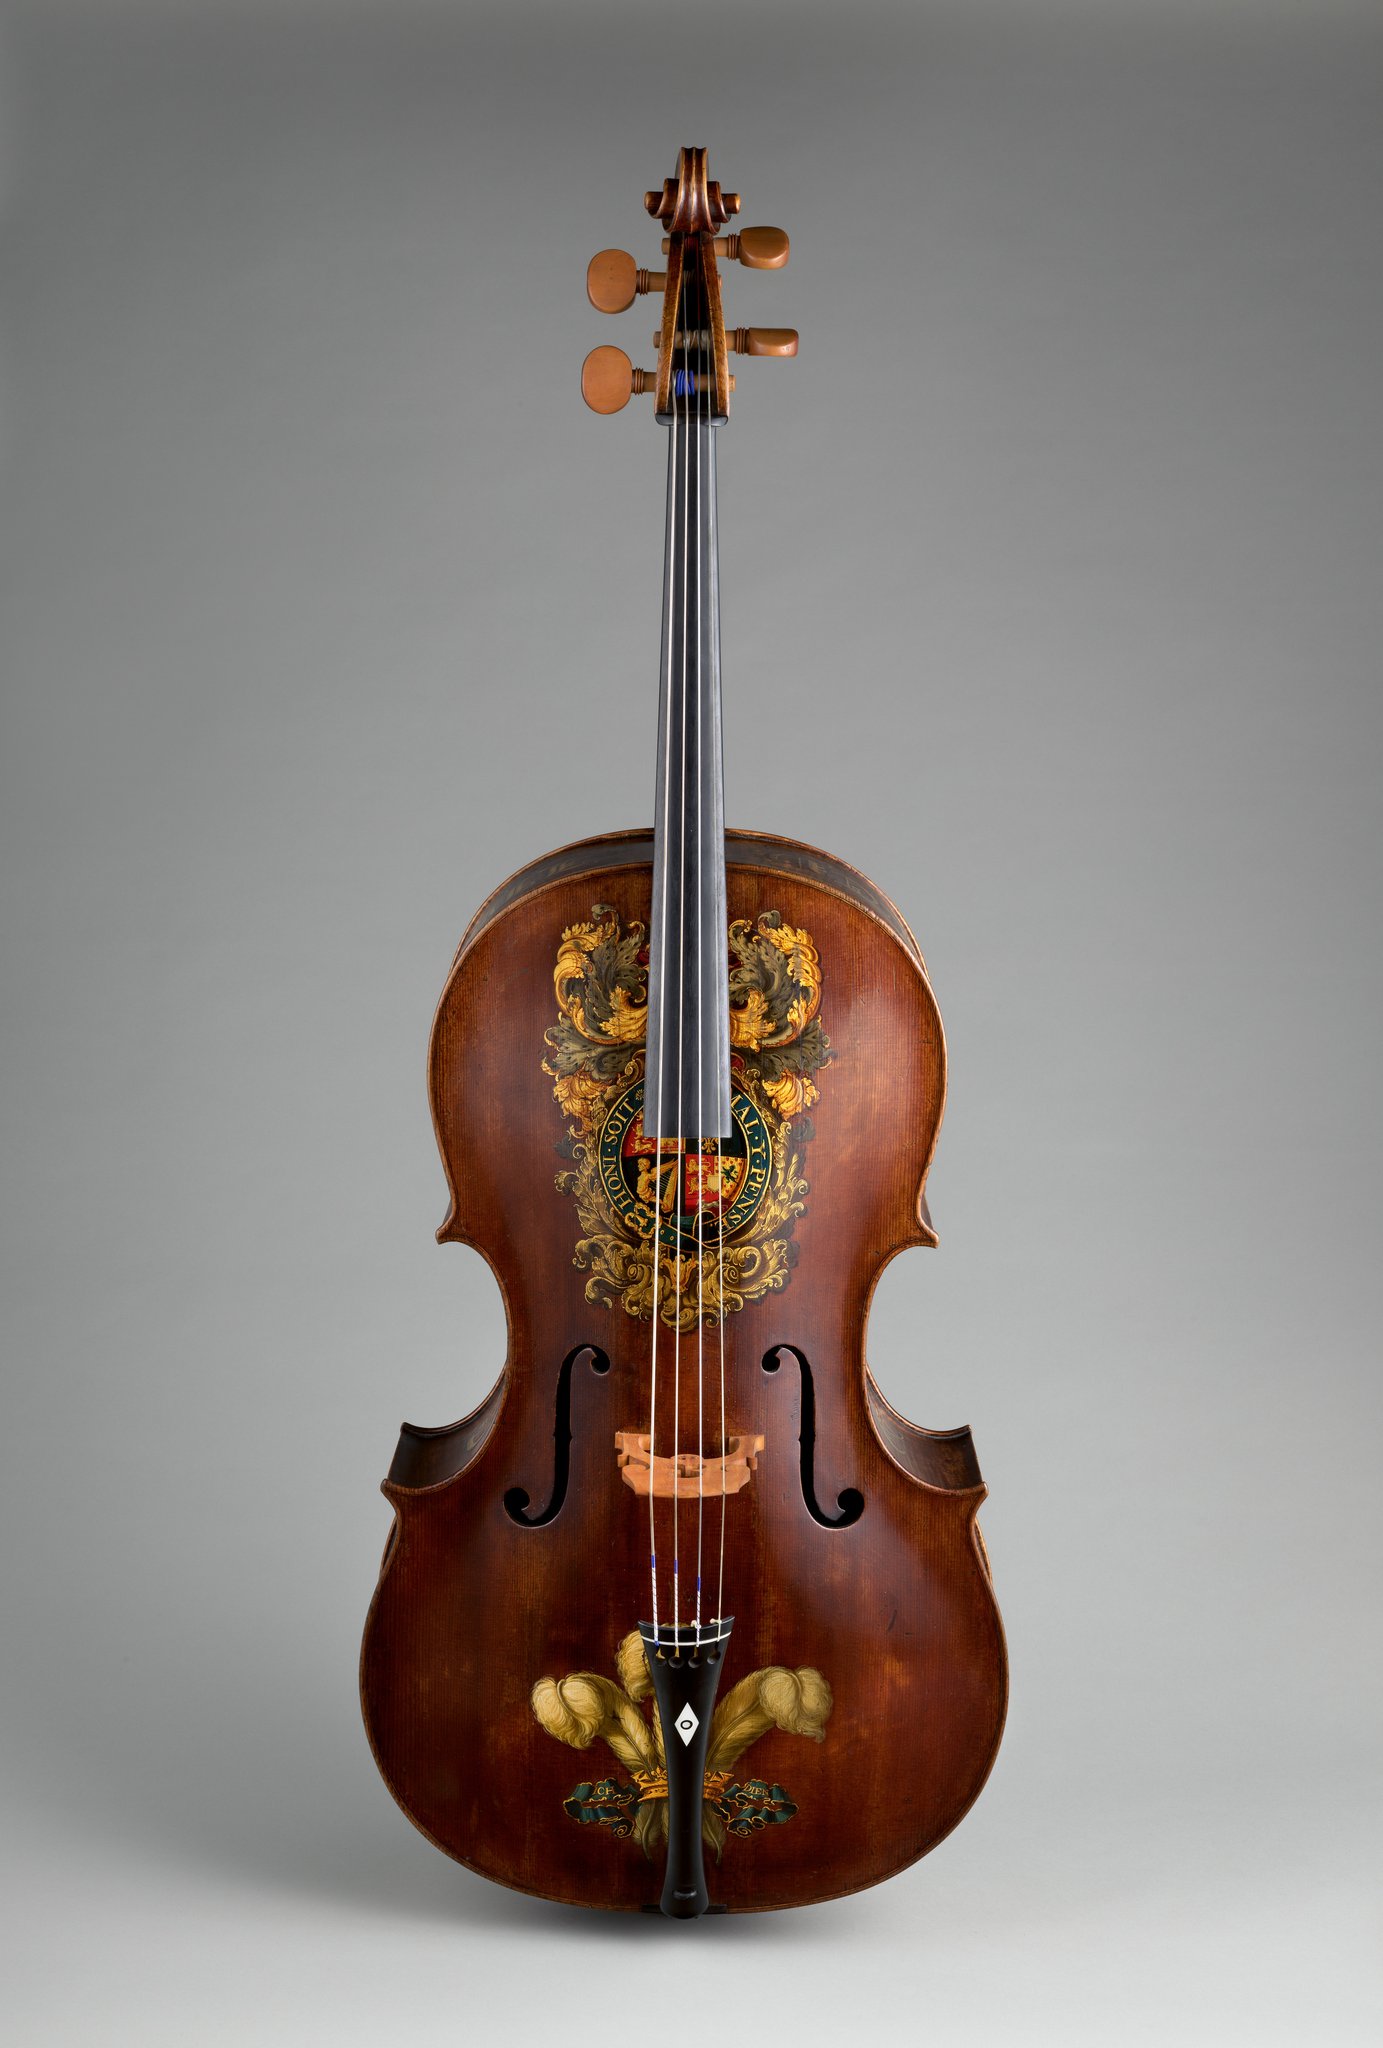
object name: violoncello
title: "Royal George" Cello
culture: british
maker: william forster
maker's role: maker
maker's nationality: british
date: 1782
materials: wood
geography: united kingdom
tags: coat of arms